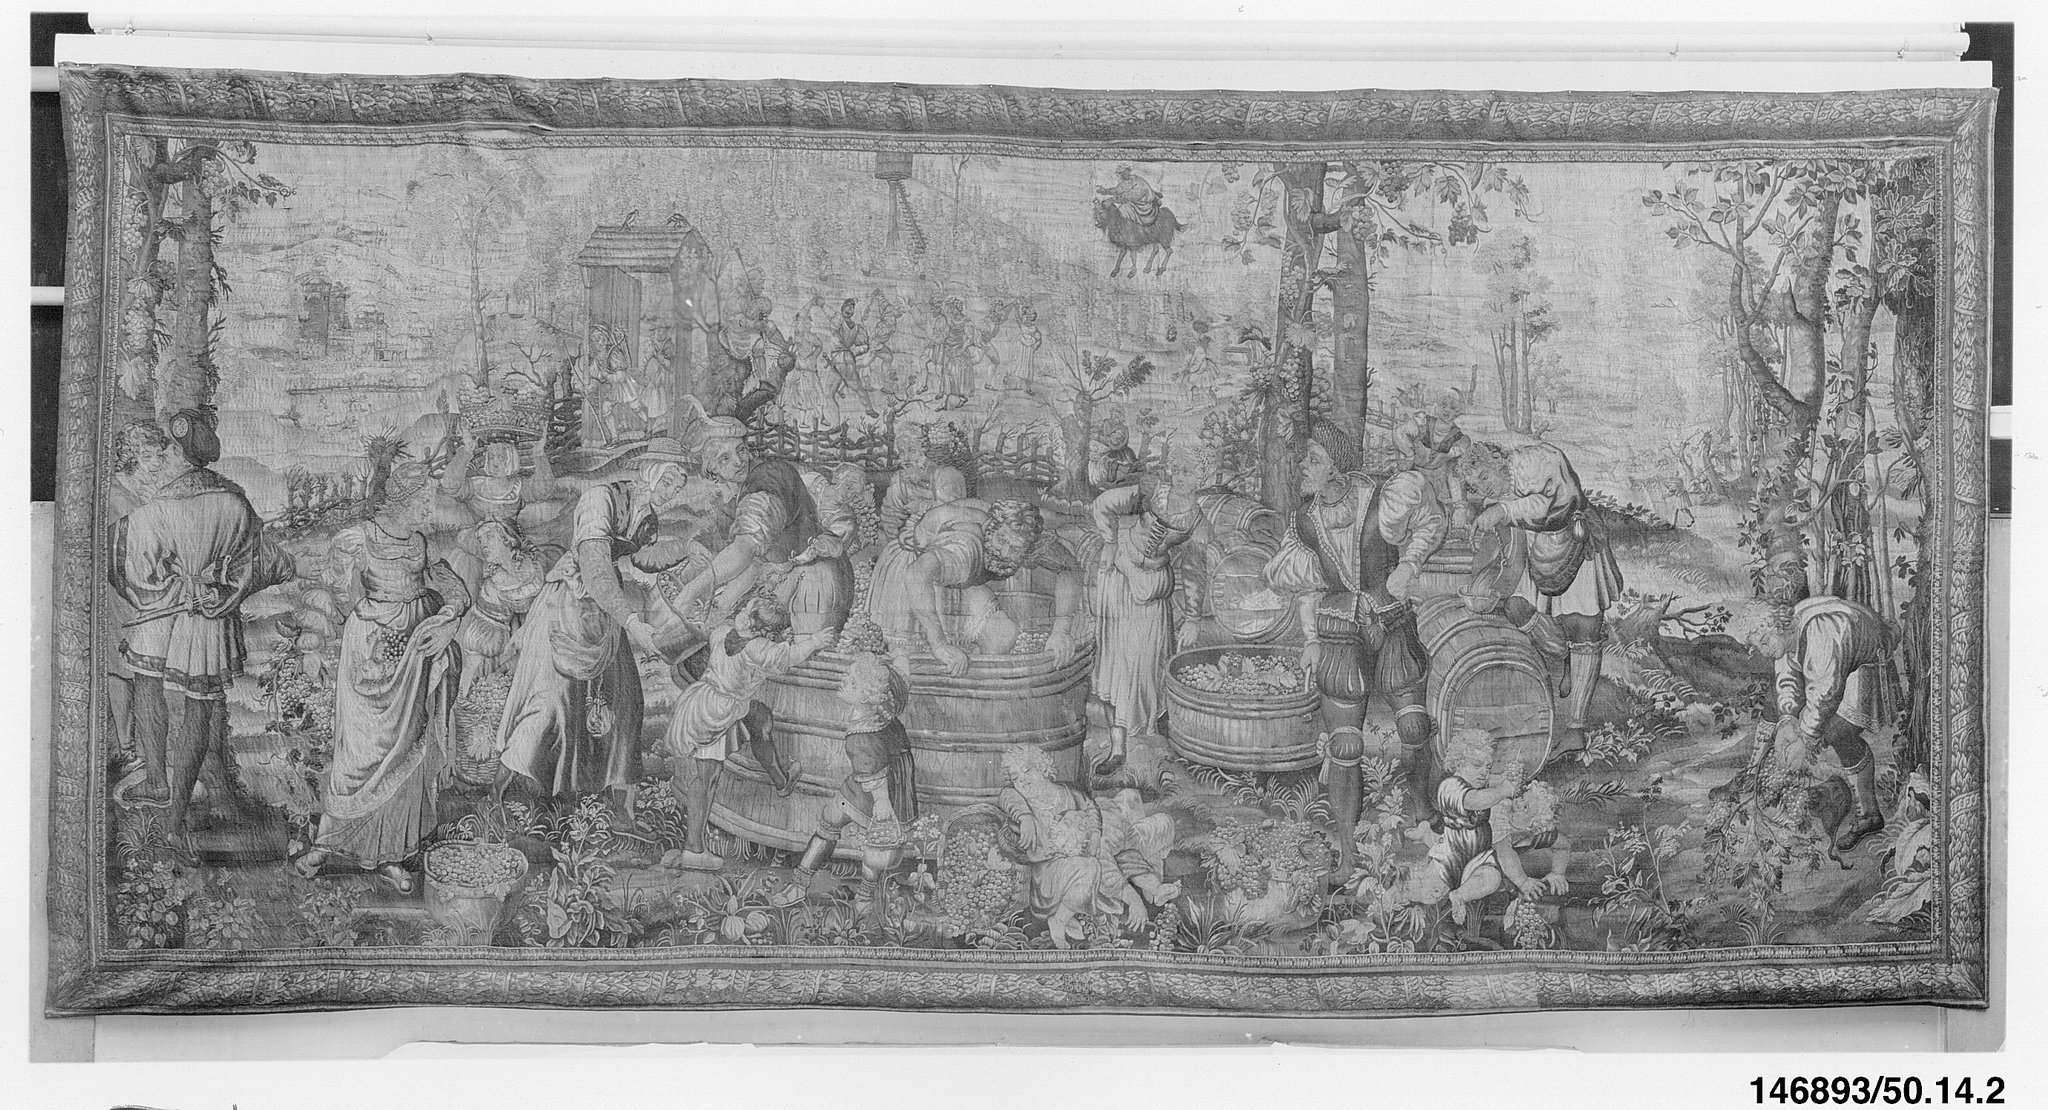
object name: tapestry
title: Autumn from a set of The Seasons of Lucas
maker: master of the months of lucas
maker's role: designer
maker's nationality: netherlandish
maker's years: 1535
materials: silk, wool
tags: men,women,autumn